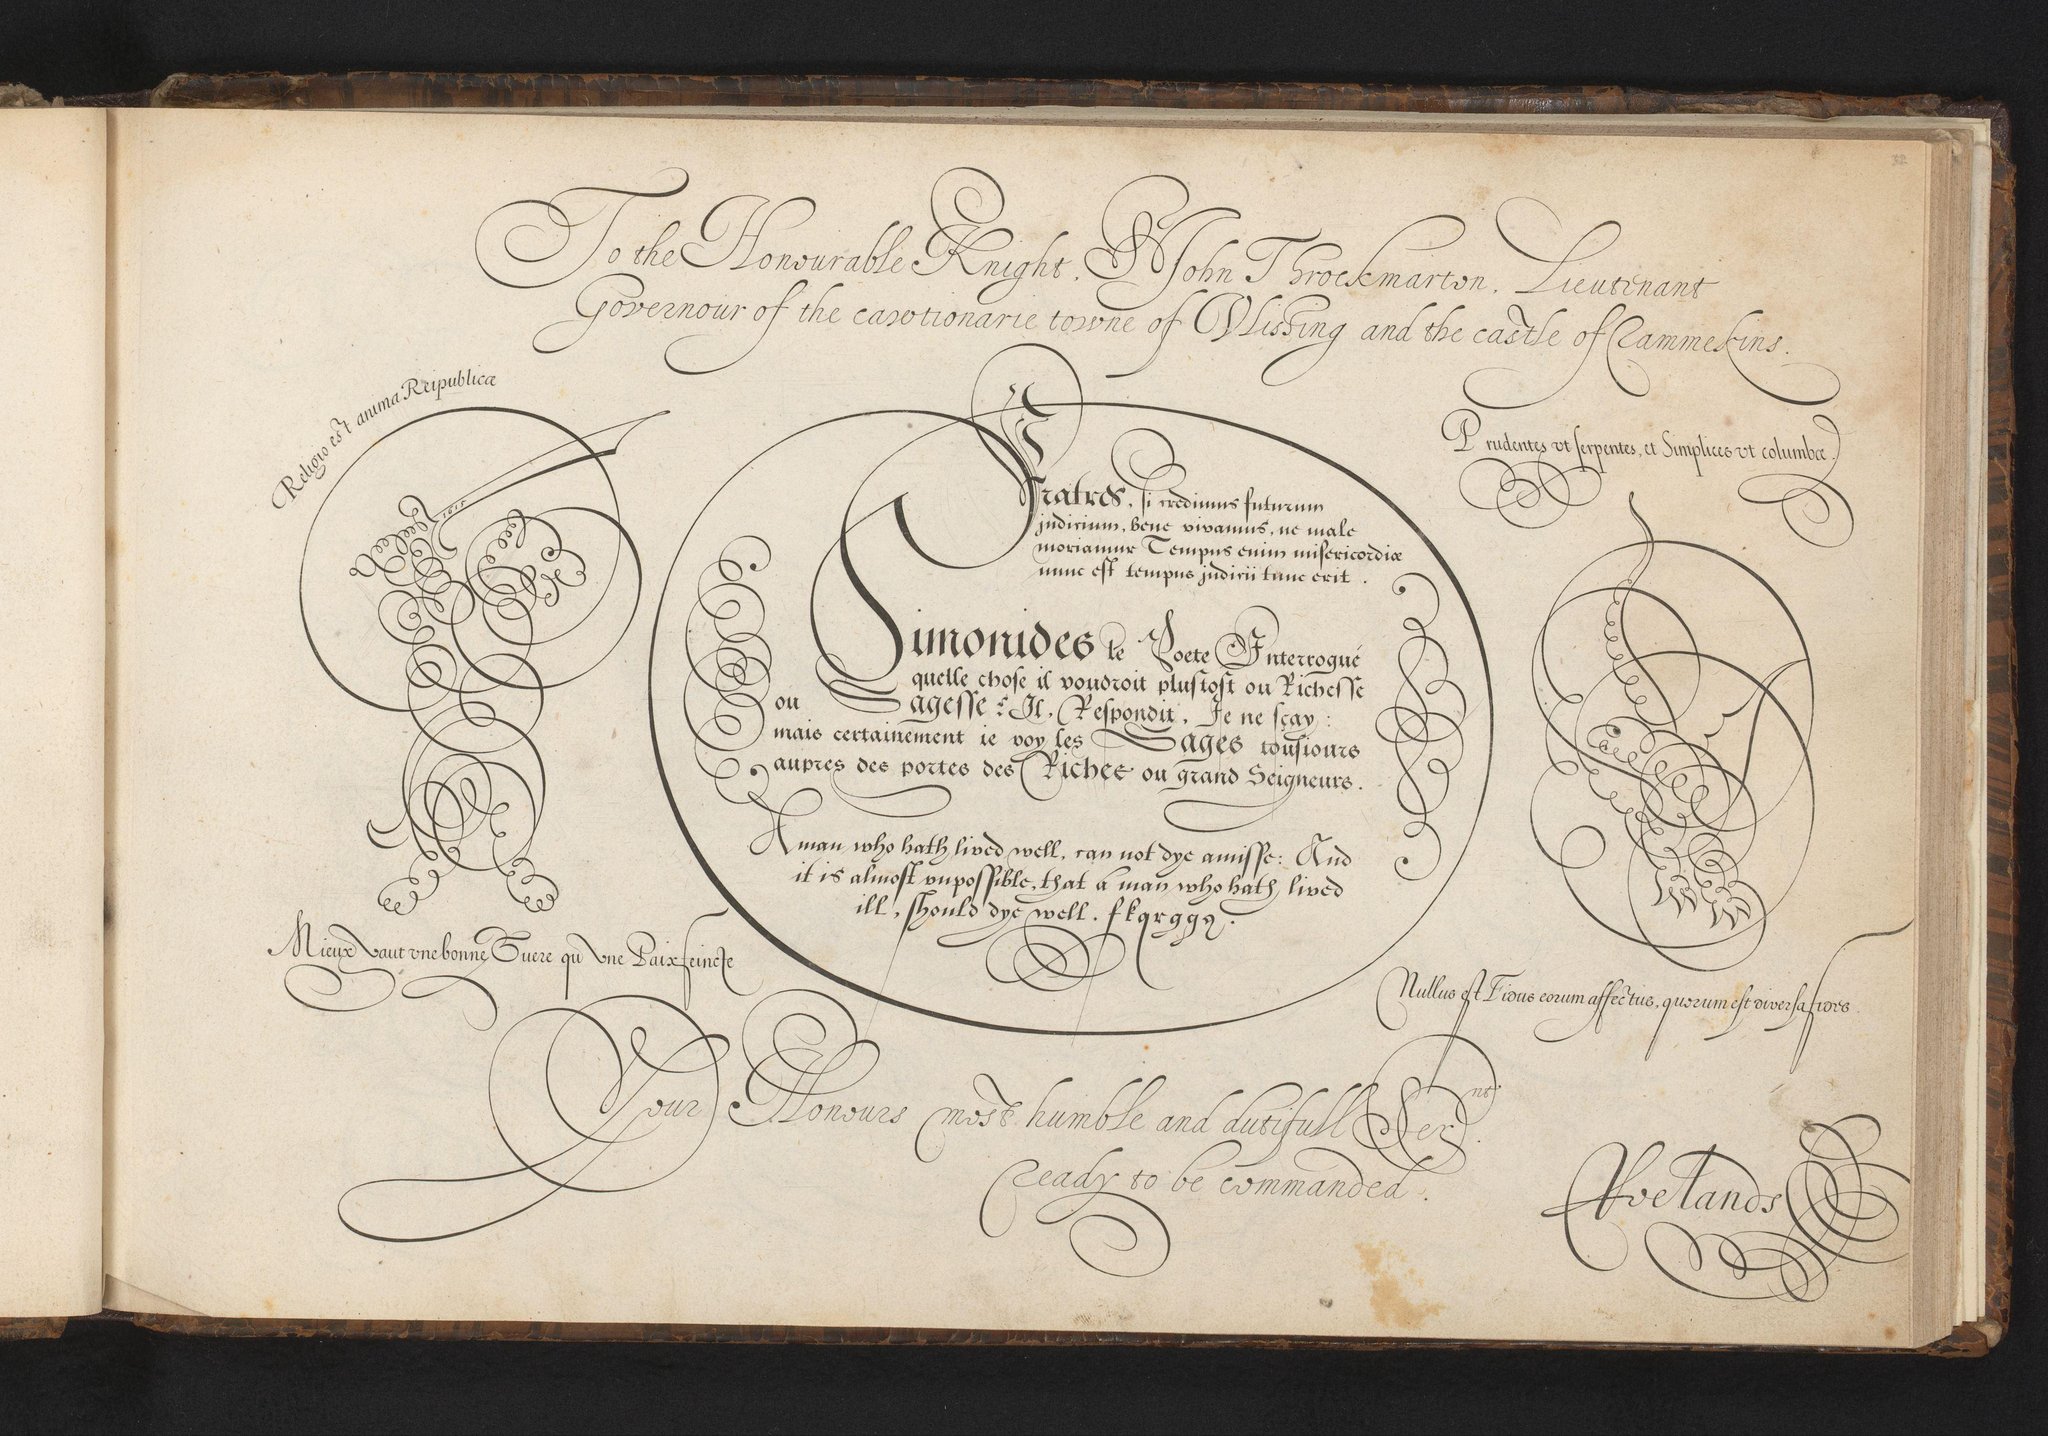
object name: ornament print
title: 't Magazin oft pac-huys der loffelycker penn-const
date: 1616-1617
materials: paper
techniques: engraving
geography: flushing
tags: calligraphy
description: Schrijfvoorbeeld met teksten in het Latijn, Frans en Engels: Fratres, si credimus ... / Simonides le Poete ... / A man who hath lived well ... Daarboven een tweeregelige tekst met een opdracht aan Sir John Throckmorton, Engels commandant van Vlissingen. De tekst wordt geflankeerd door een beer met zwaard en een gevleugelde draak in krulwerk. De prent maakt deel uit van een album.